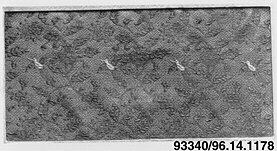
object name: piece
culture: japanese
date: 1701-1900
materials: silk